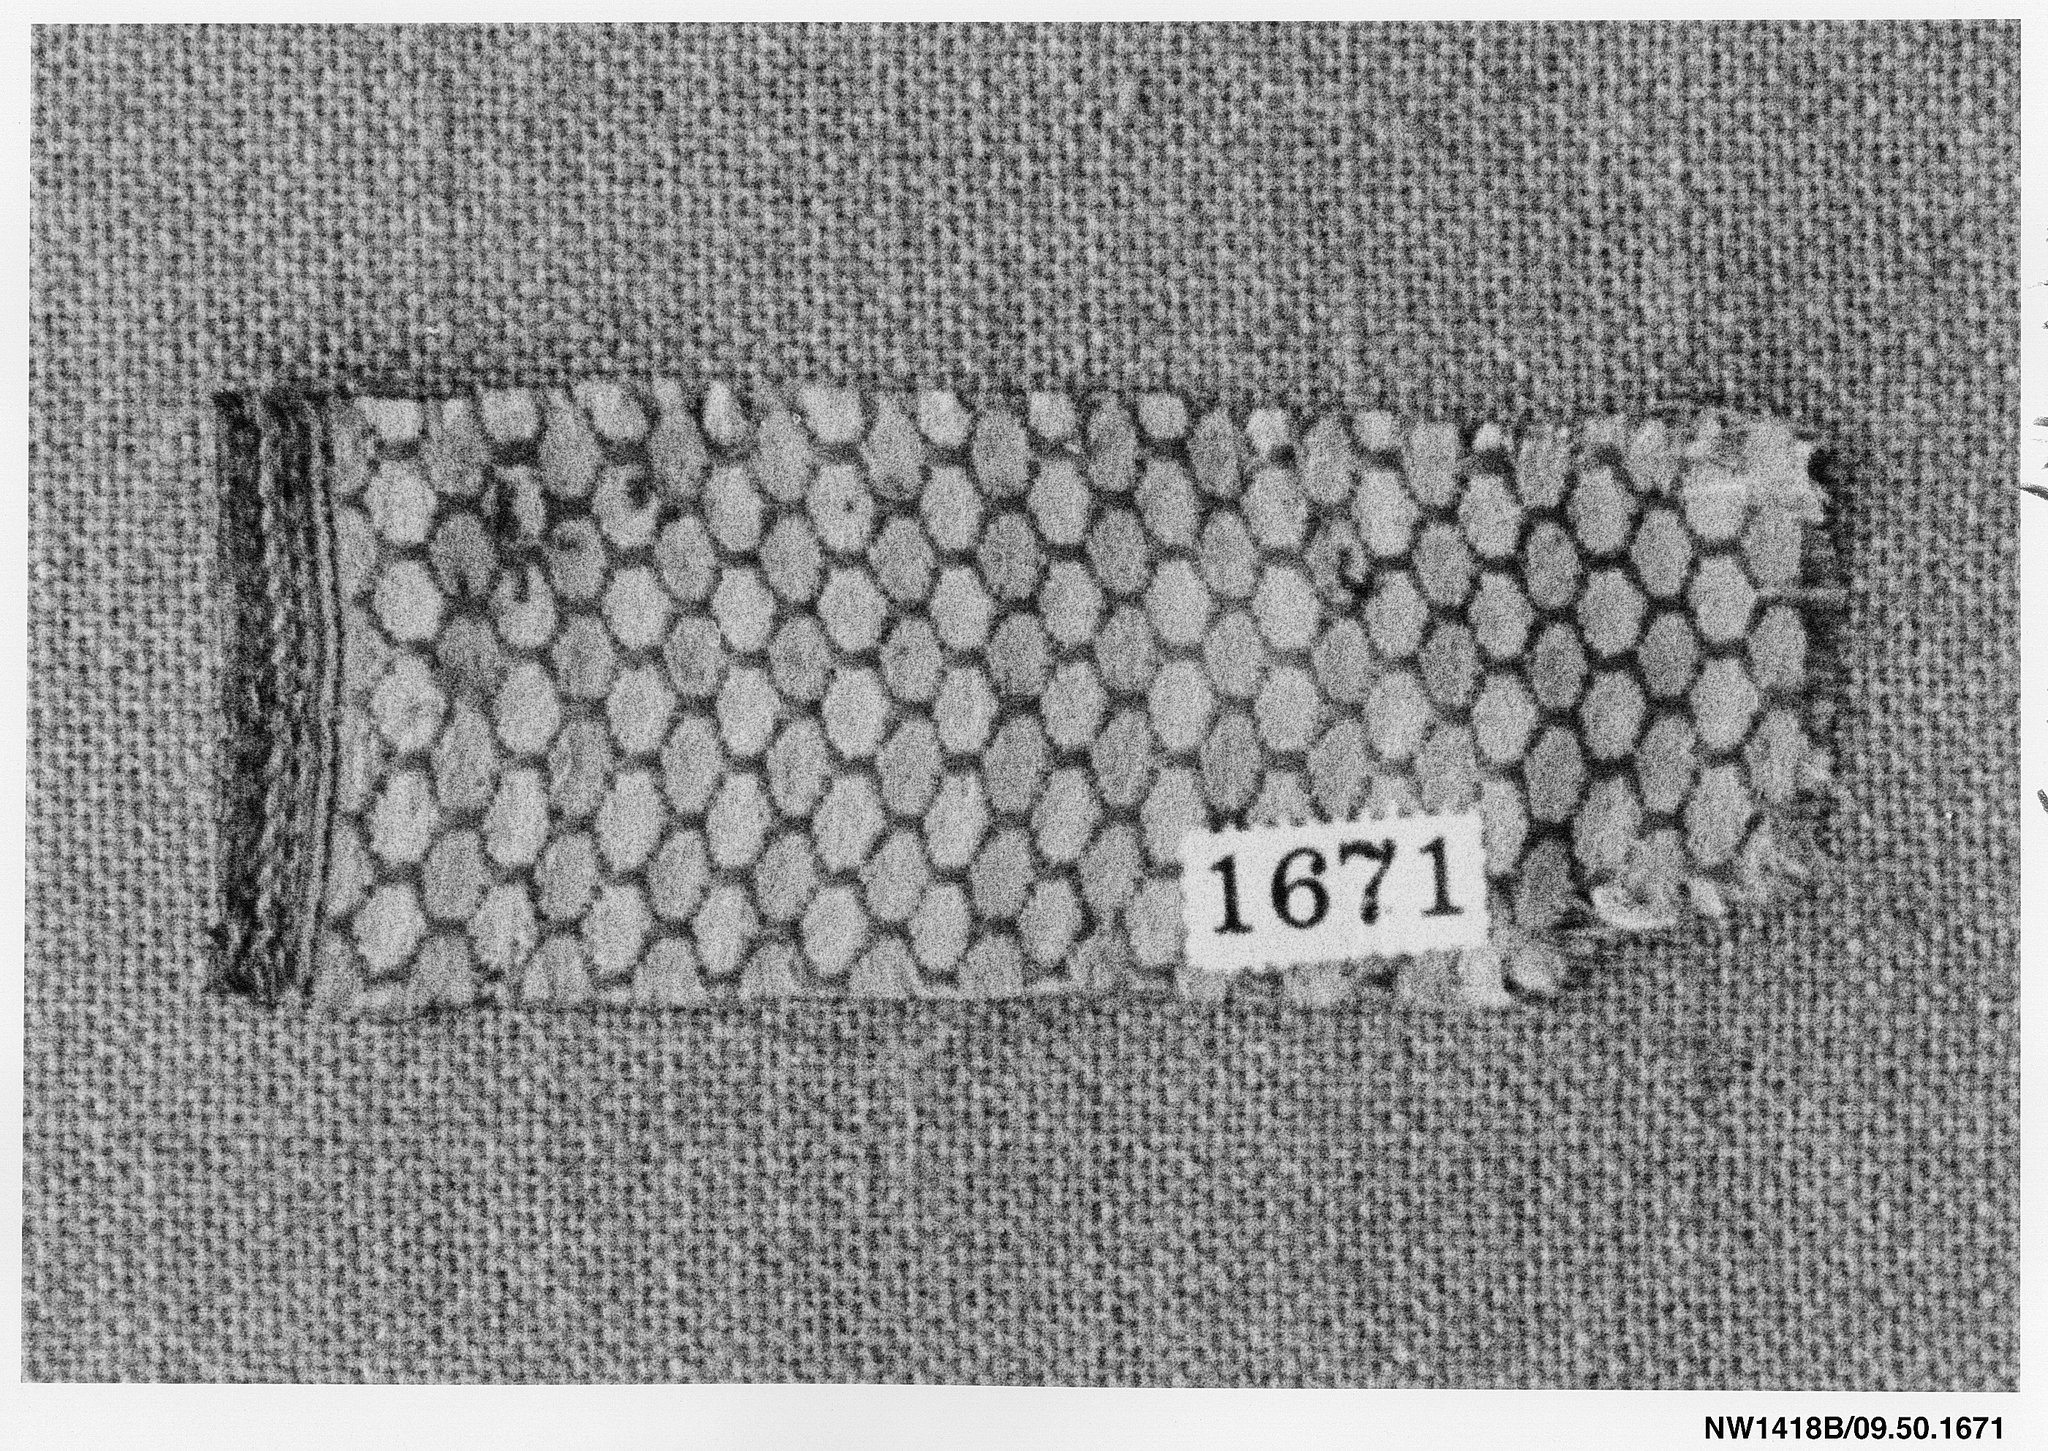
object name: piece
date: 1701-1800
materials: silk